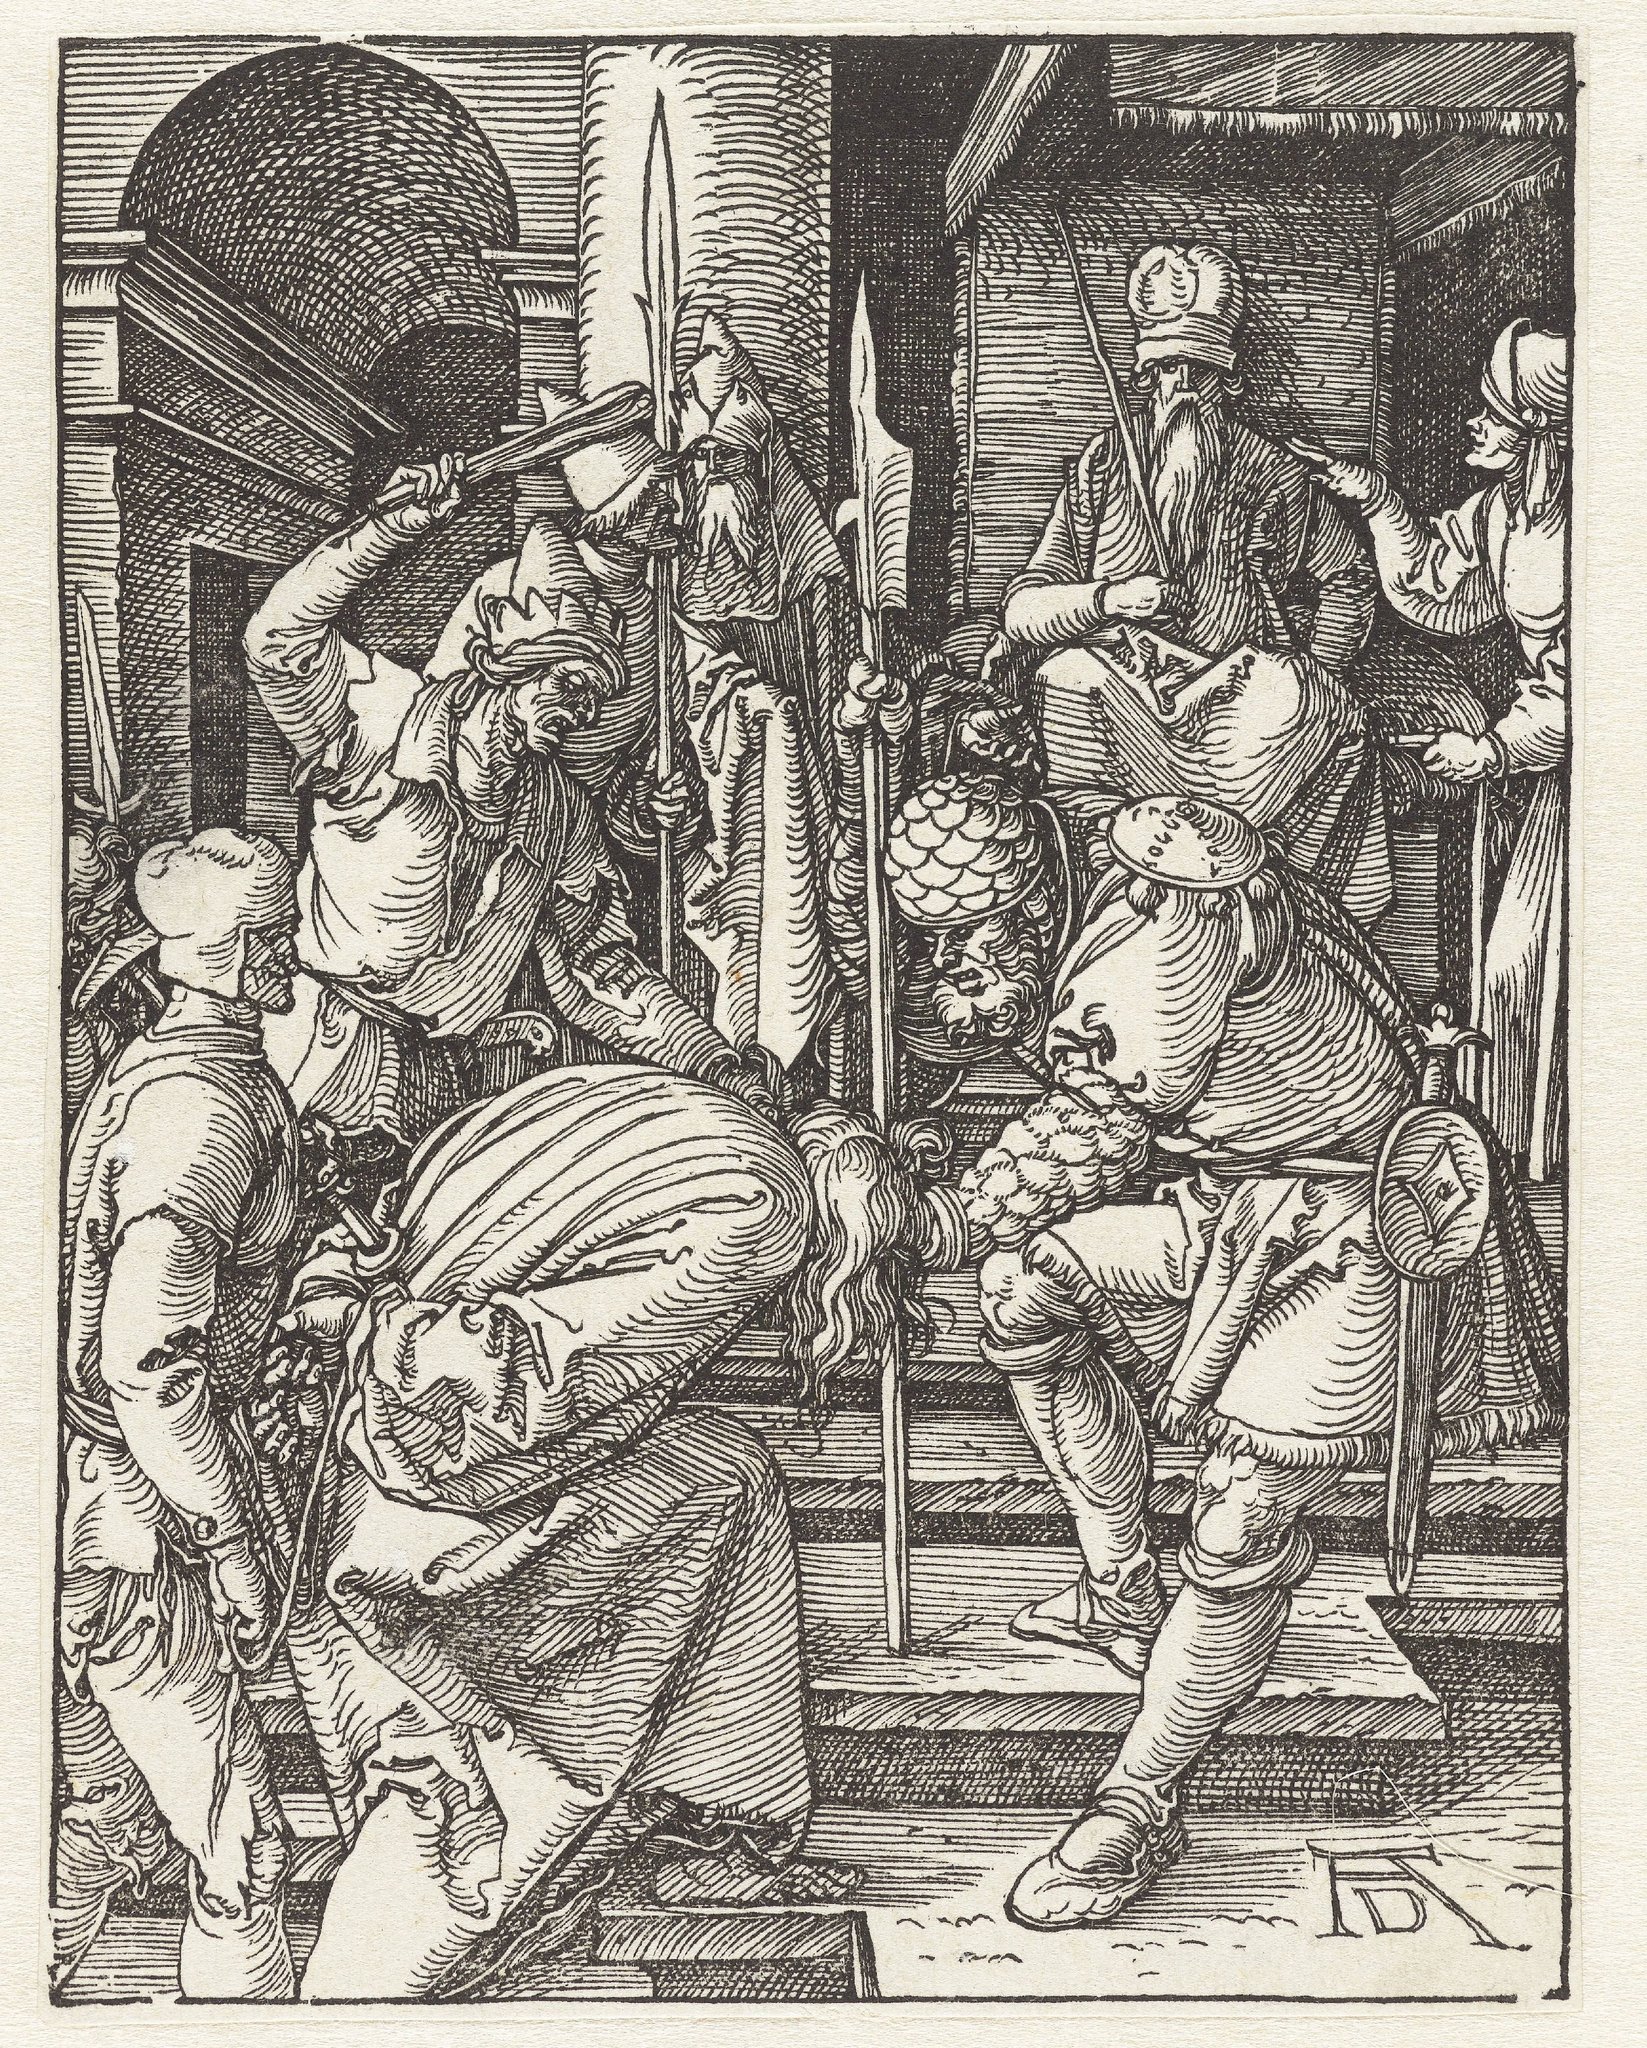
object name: print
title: De kleine Passie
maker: albrecht dürer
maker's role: draughtsman, painter, print maker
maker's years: 1471-1528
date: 1508-1509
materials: paper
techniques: woodcut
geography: nuremberg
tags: christ before annas (hanna); maybe a soldier about to strike christ (john 18:13, 18:19-24)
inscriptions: collector's mark: Lugt 2228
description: Christus wordt door gewapende mannen voor Annas geleid. Deze prent is onderdeel van de prentserie 'De kleine Passie', bestaande uit een titelprent en 36 bijbelse scènes (voornamelijk uit het Lijdensverhaal).